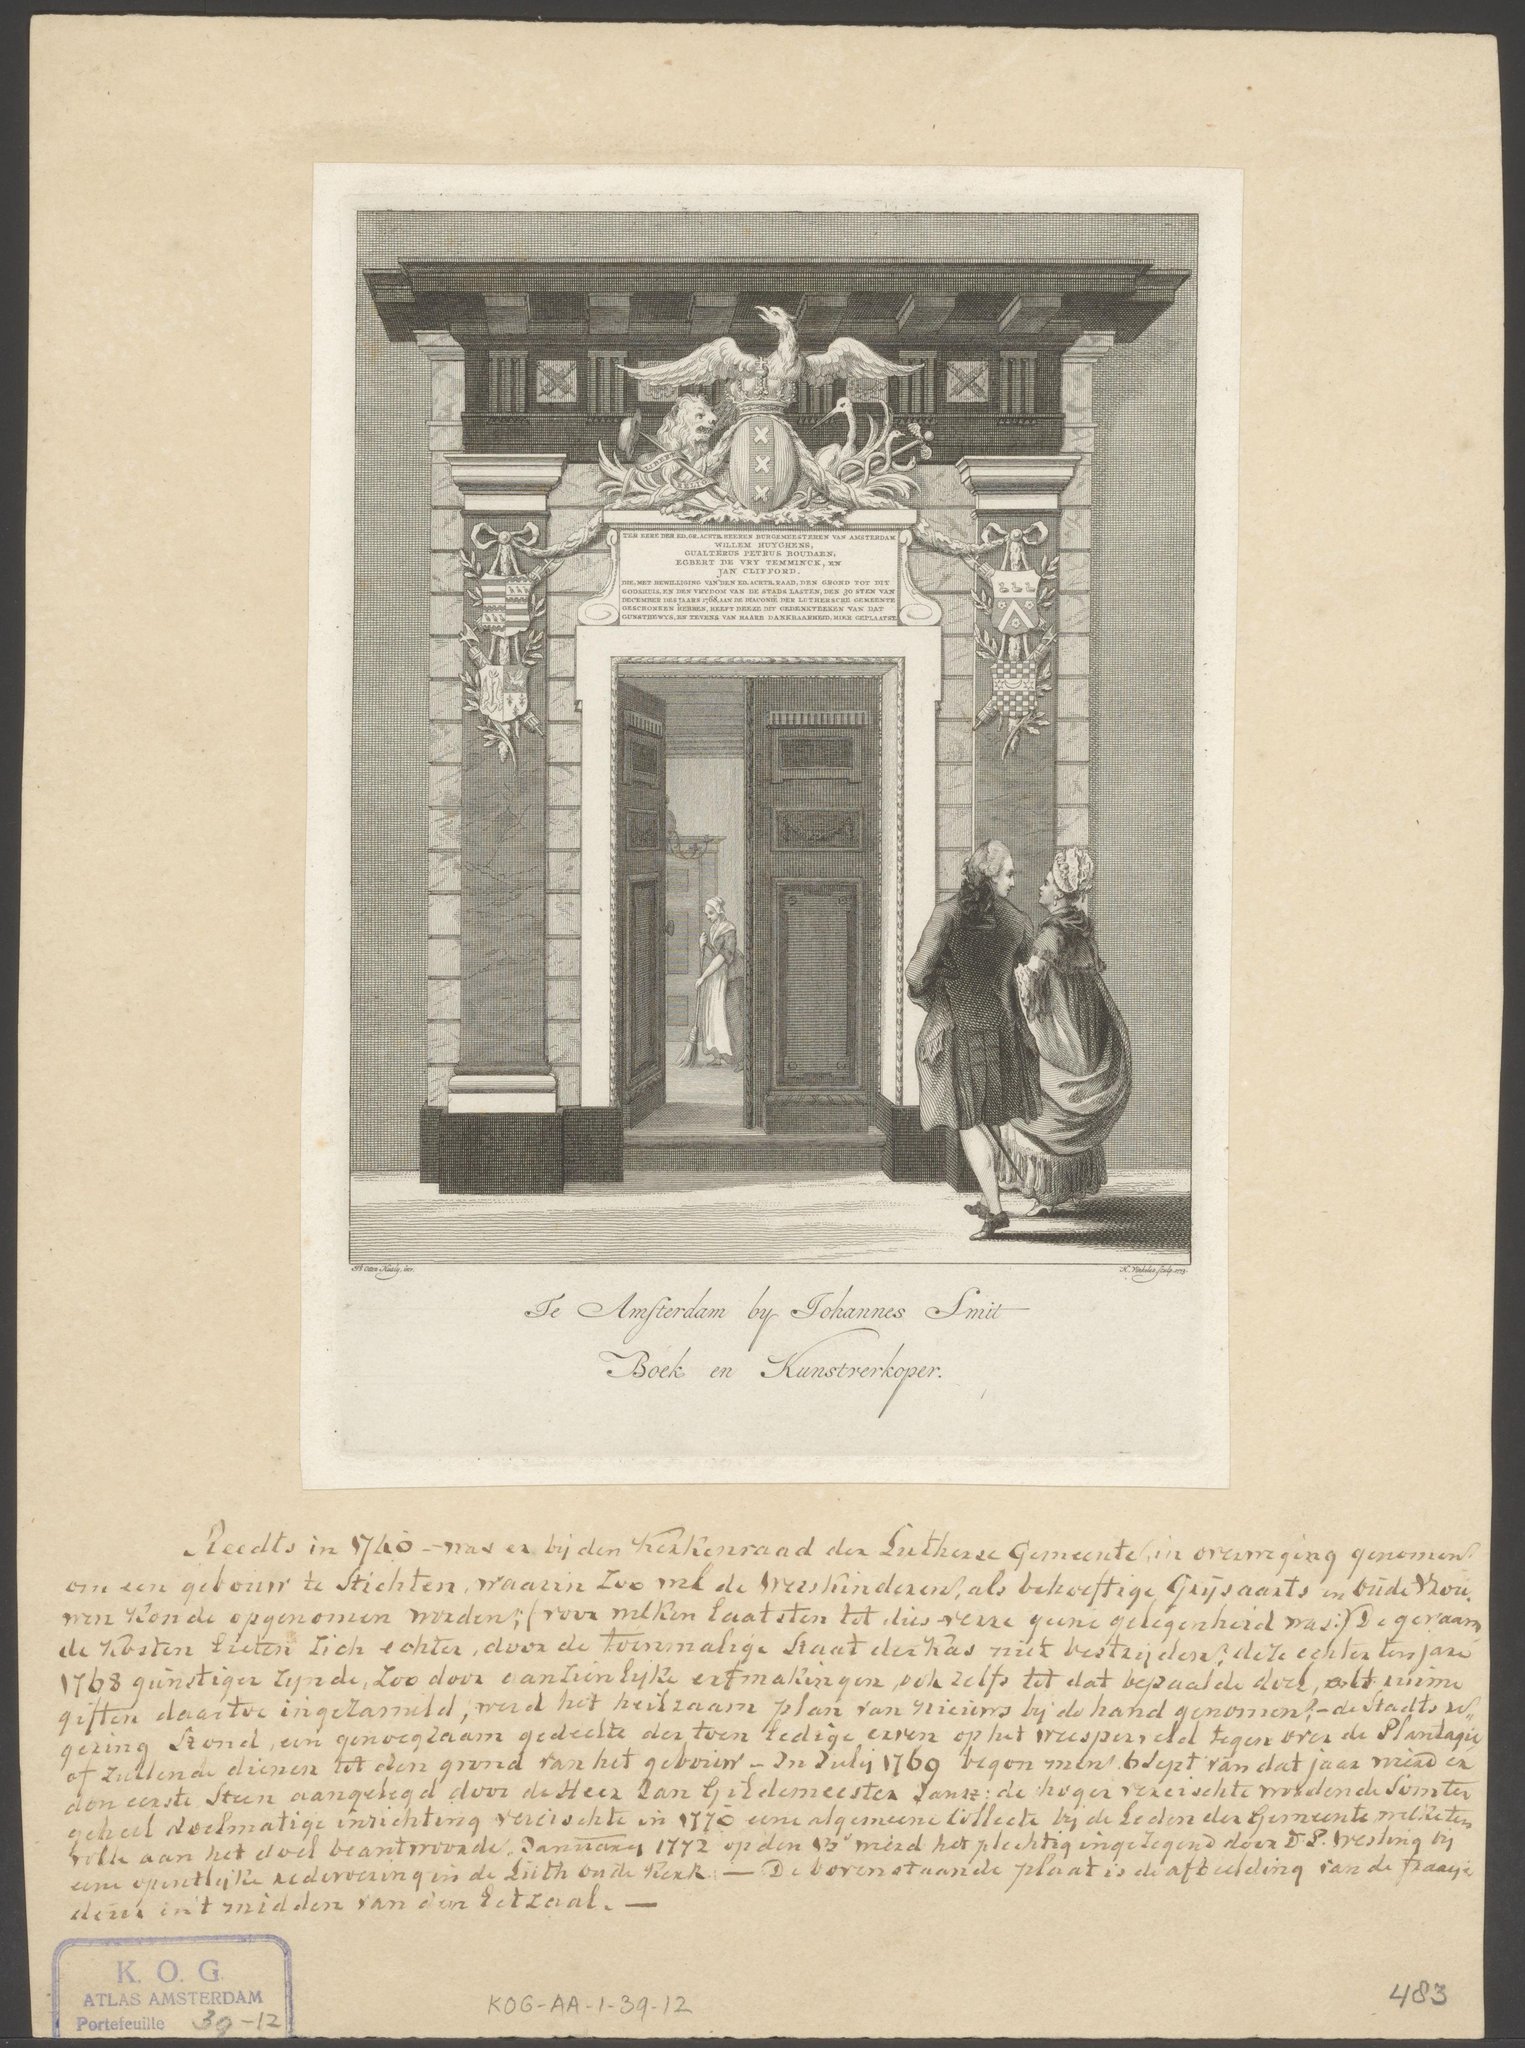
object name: print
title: Poort van het Lutherse Diaconiehuis te Amsterdam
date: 1773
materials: paper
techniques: engraving, etching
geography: northern netherlands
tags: gate, entrance, old-people's home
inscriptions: collector's mark: Lugt 1641b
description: Onderwerpsrubriek binnen de Atlas Amsterdam: Armwezen en liefdadige instellingen: II. Kerkelijke inrichtingen: Inrichtingen der Evang. Luthersen.